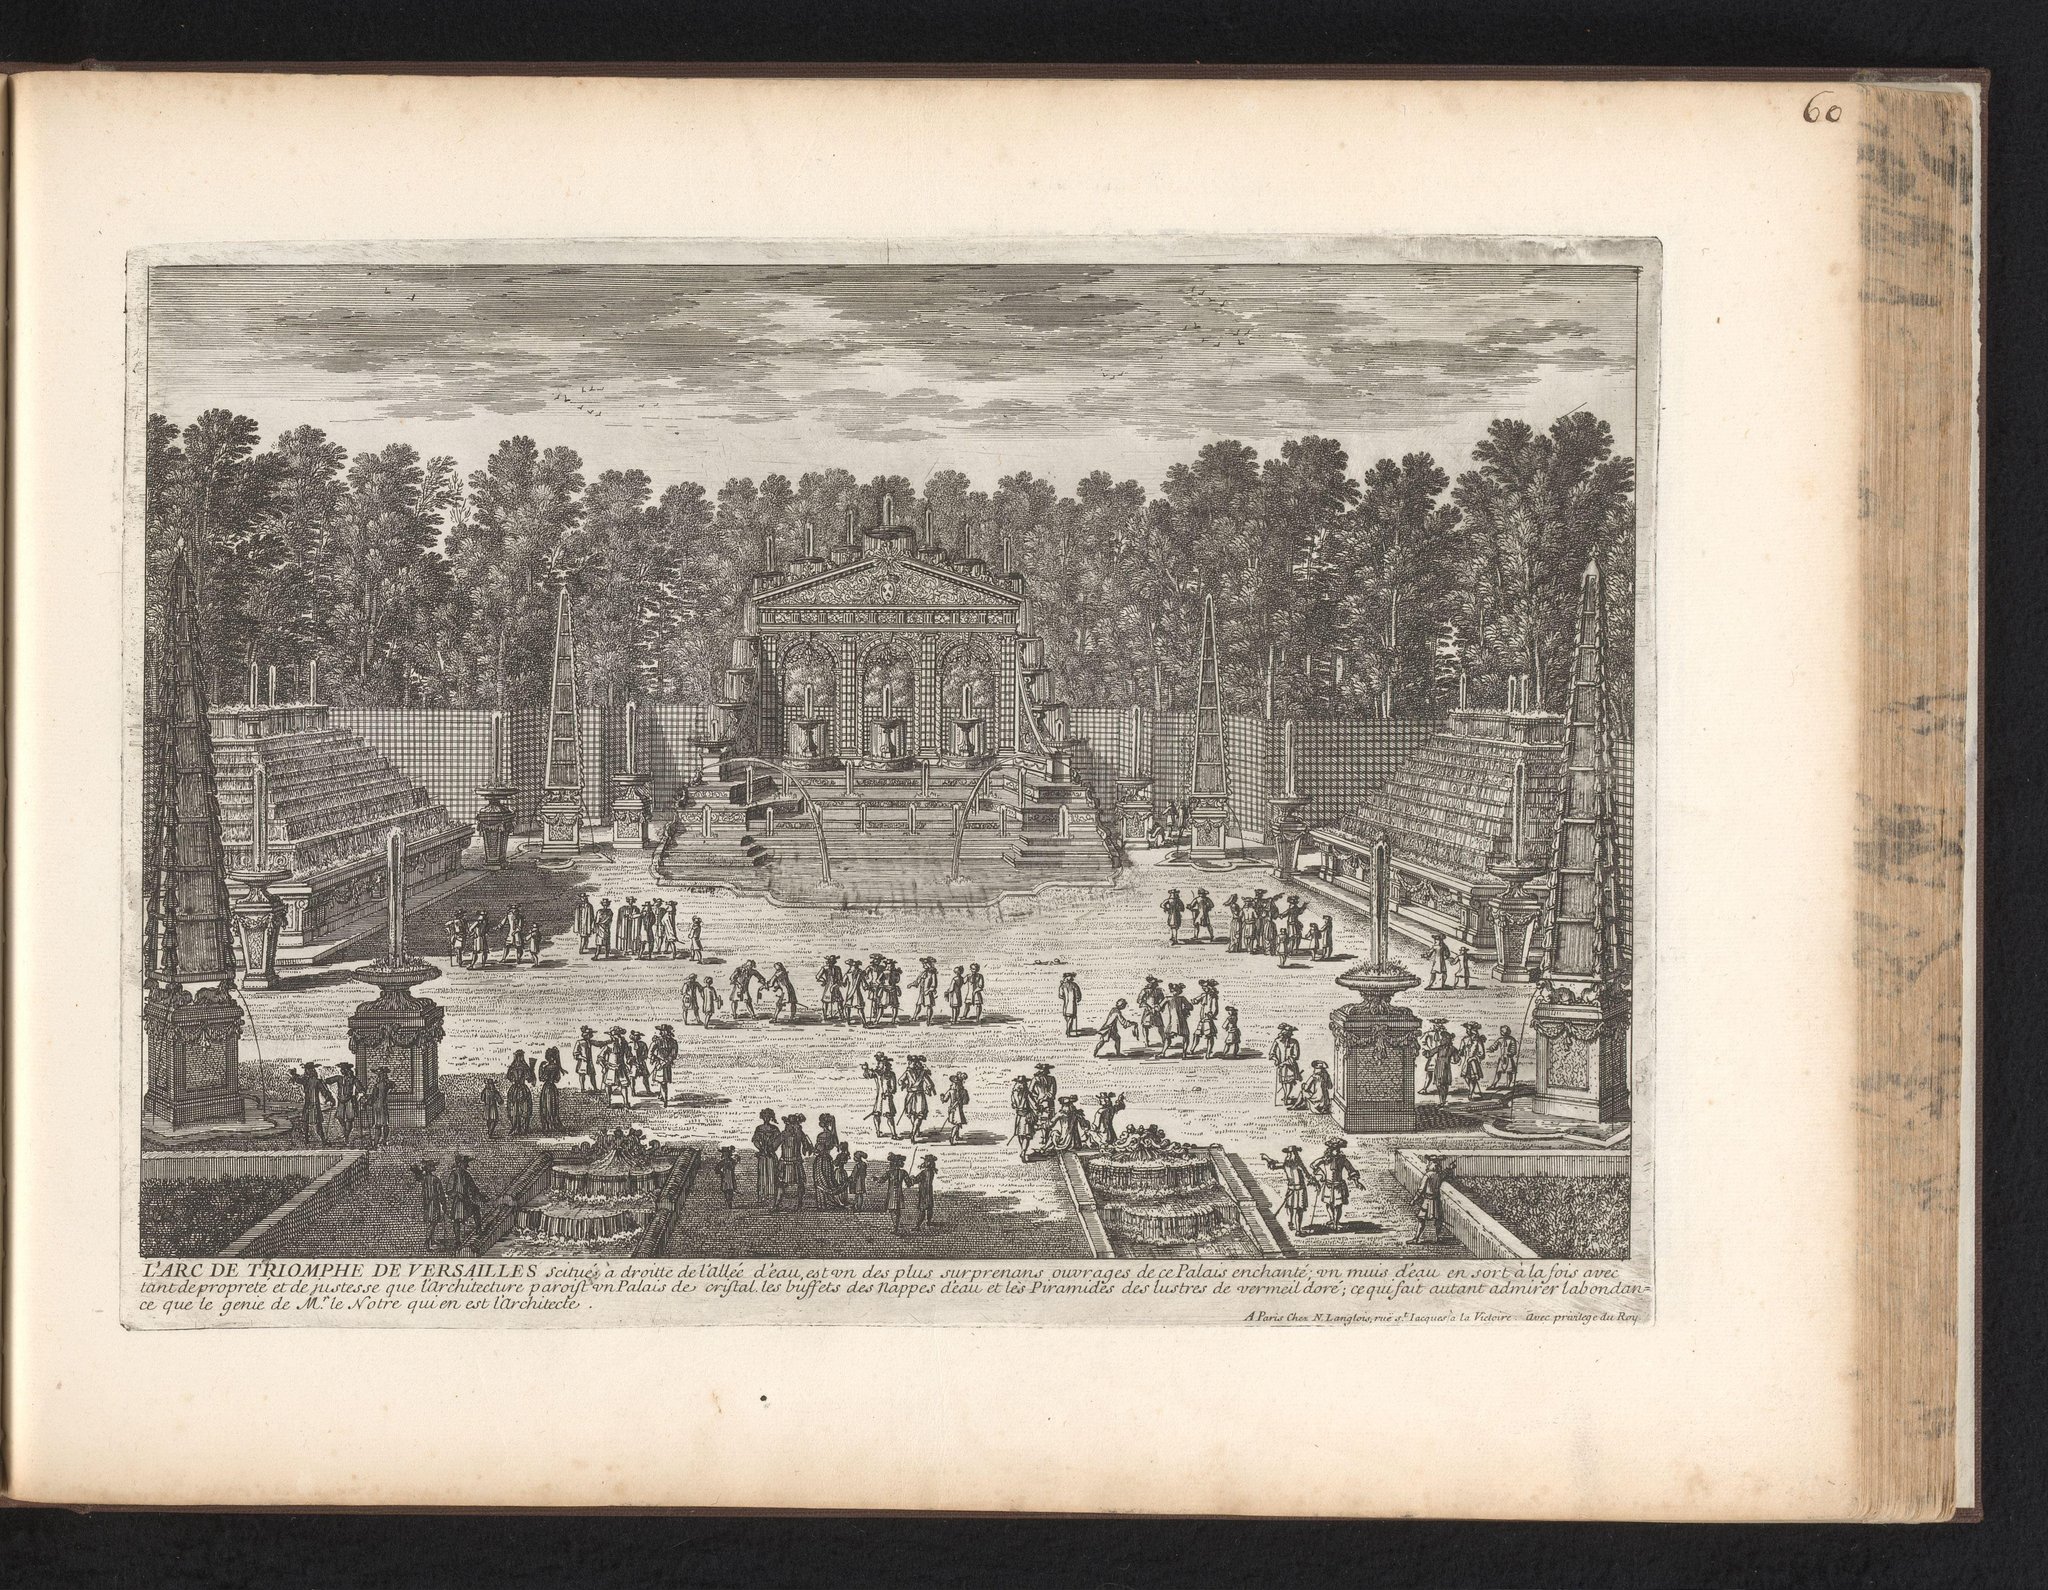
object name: print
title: Recueil de vues de monuments de Paris, des principales résidences royales et des principaux châteaux de France et de Rome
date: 1670-1695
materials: paper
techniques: etching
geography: paris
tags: garden fountain, french or architectonic garden; formal garden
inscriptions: collector's mark: Lugt 2228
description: Prenten met het signatuur 'Perelle' kunnen zowel door vader Gabriel als door zonen Nicolas en Adam gemaakt zijn. De uitgevers vader en zoon Nicolas Langlois worden allebei vermeld als N. Langlois op hetzelfde adres.